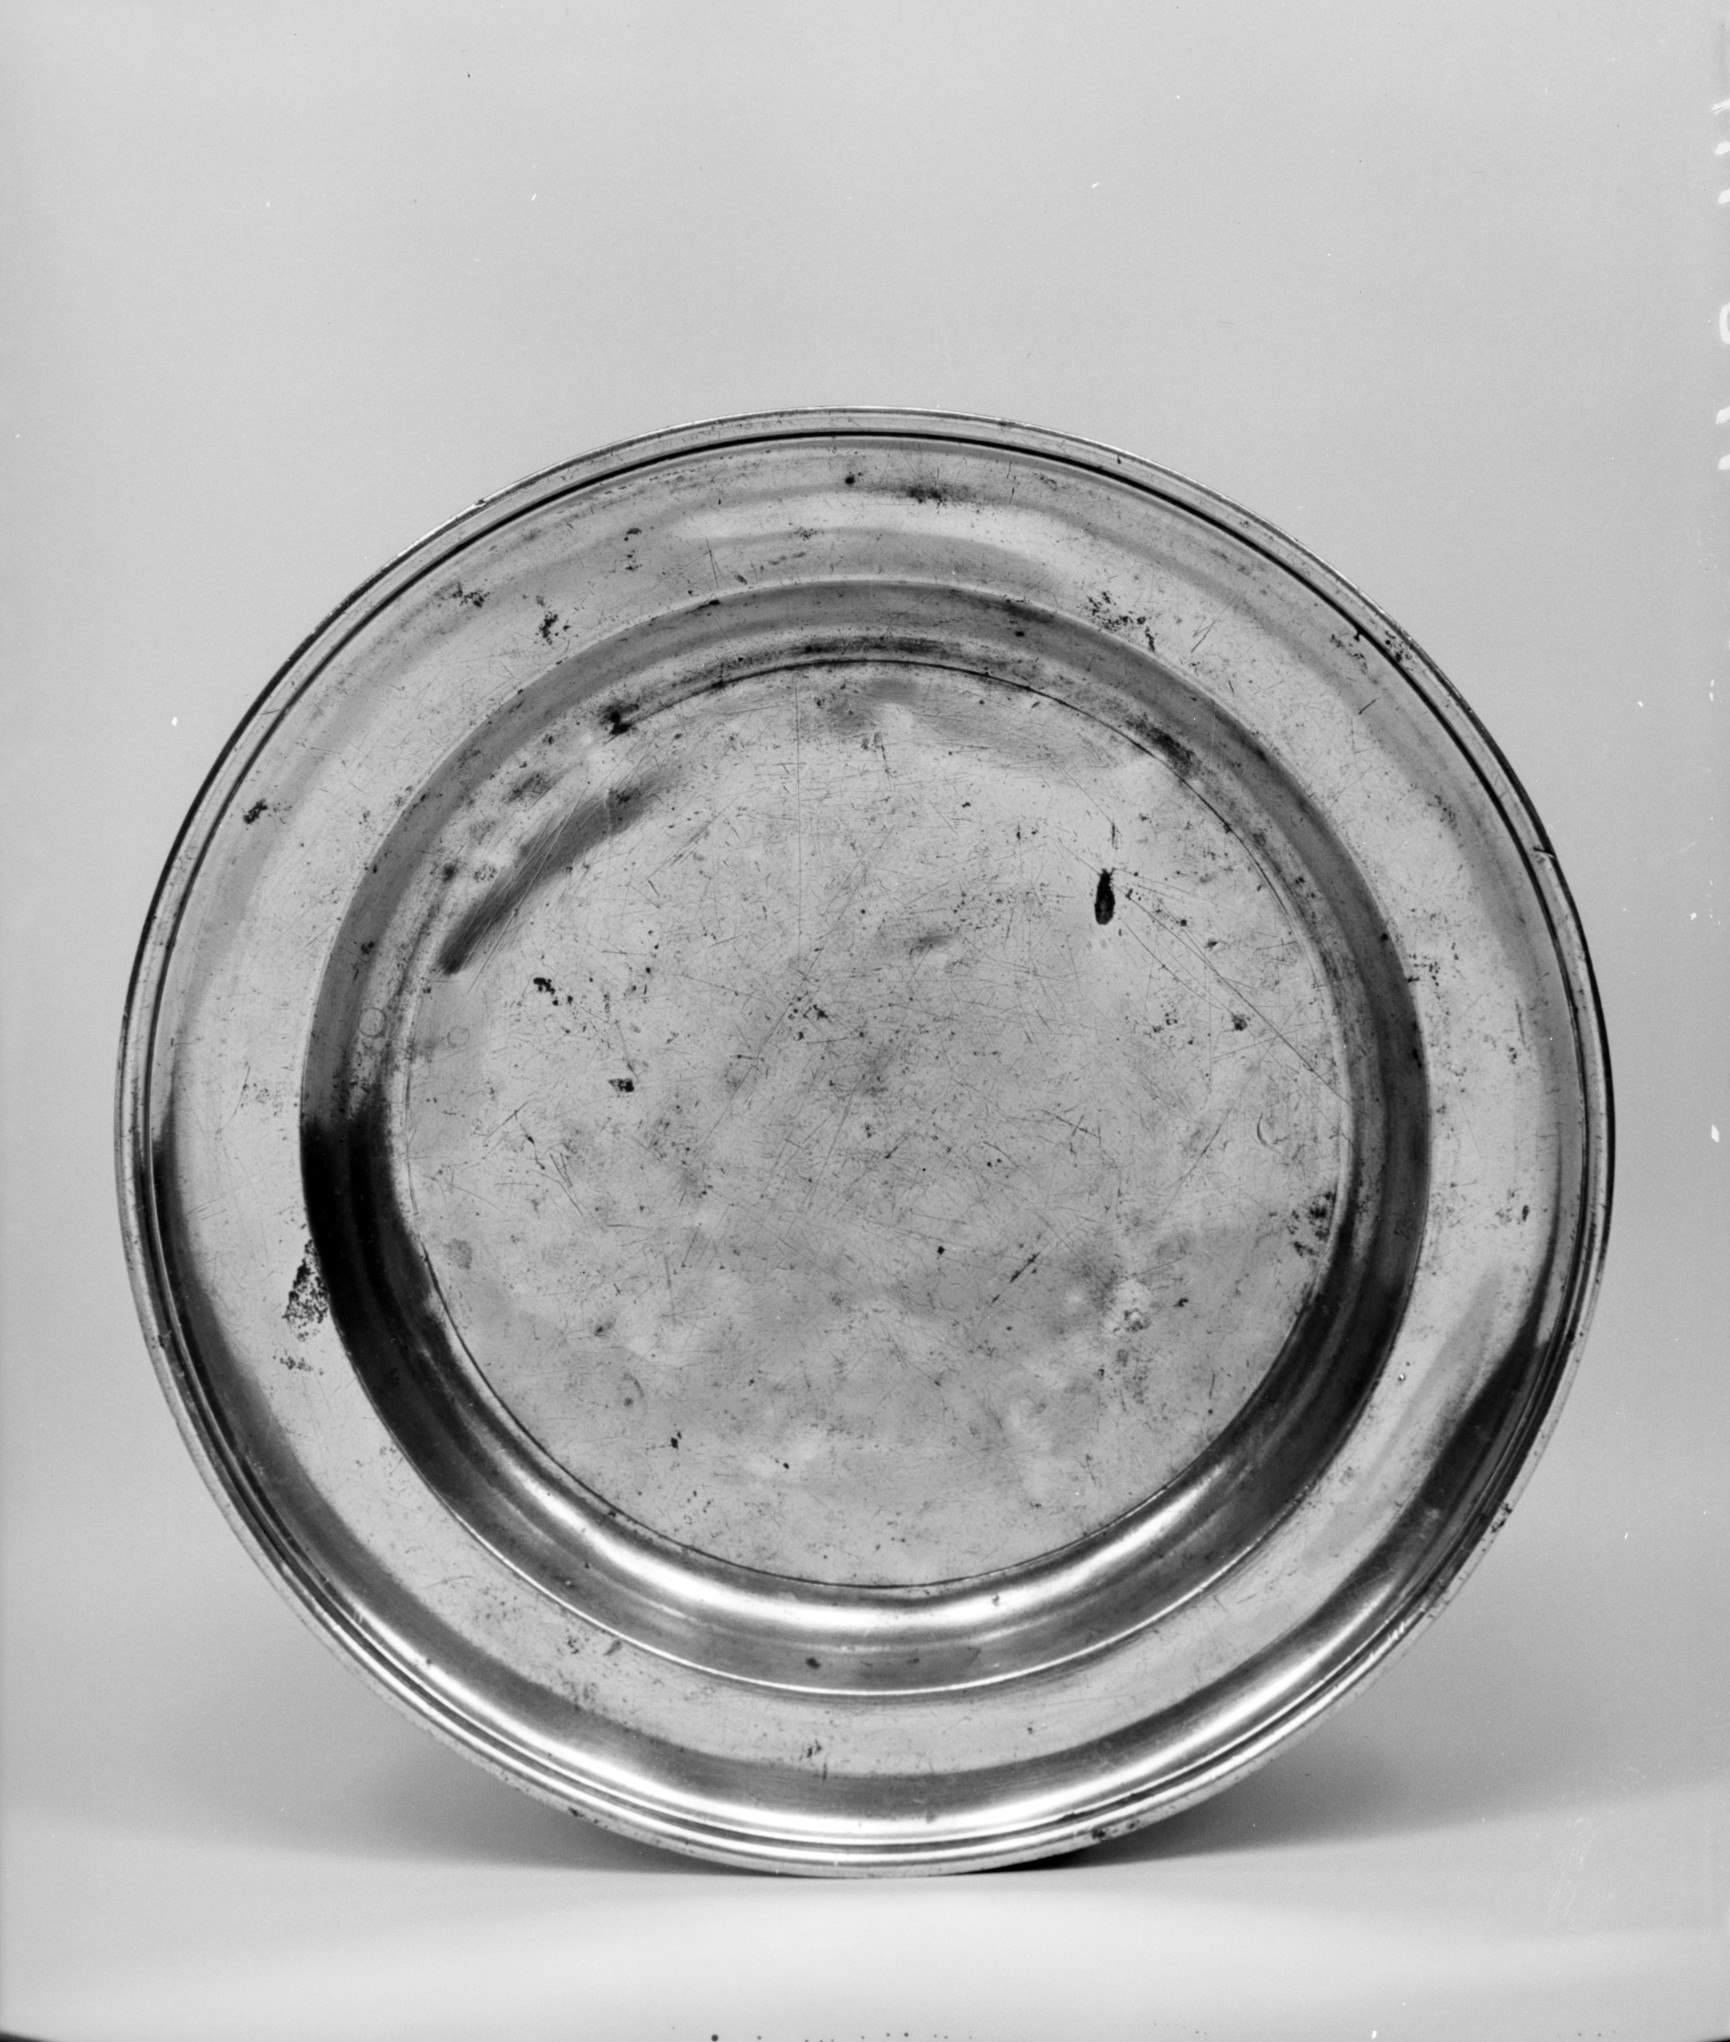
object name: dish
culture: american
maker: gershom jones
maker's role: maker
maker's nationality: american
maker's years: 1751-1809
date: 1774-1809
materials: pewter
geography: united states